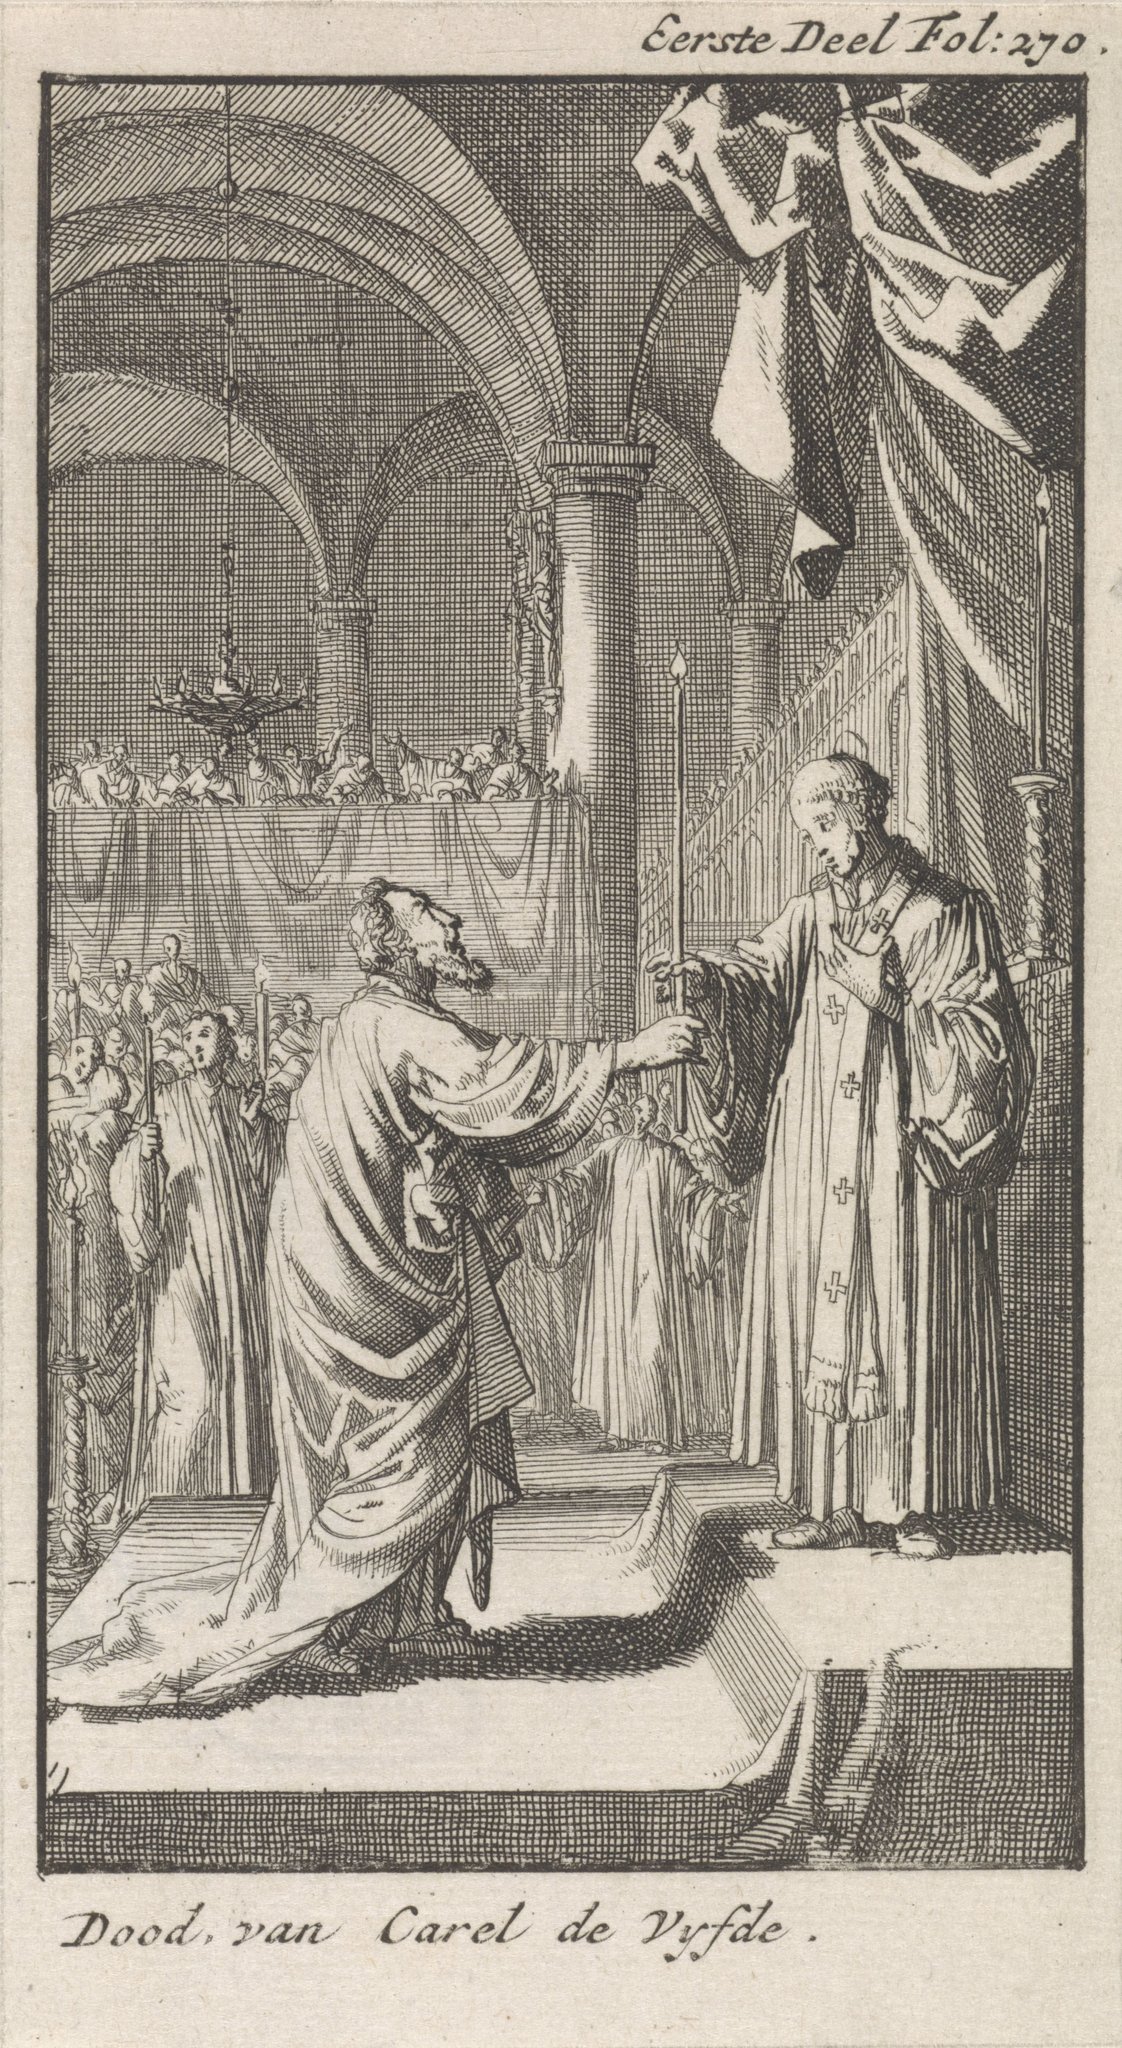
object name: history print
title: Dood van Carel de Vyfde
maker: jan luyken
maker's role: draughtsman, print maker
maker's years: 1649-1712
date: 1699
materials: paper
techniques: etching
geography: amsterdam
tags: ghent, charles v (holy roman emperor and king of spain)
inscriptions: collector's mark: Lugt 2228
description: Boekillustratie voor Leti, Gregorio. Het Leven van Filips de II, Koning van Spanien. Vertaald door N.J. Wieringa. Den Haag: Engelbreght Boucquet, 1699, dl.1, f. 270.